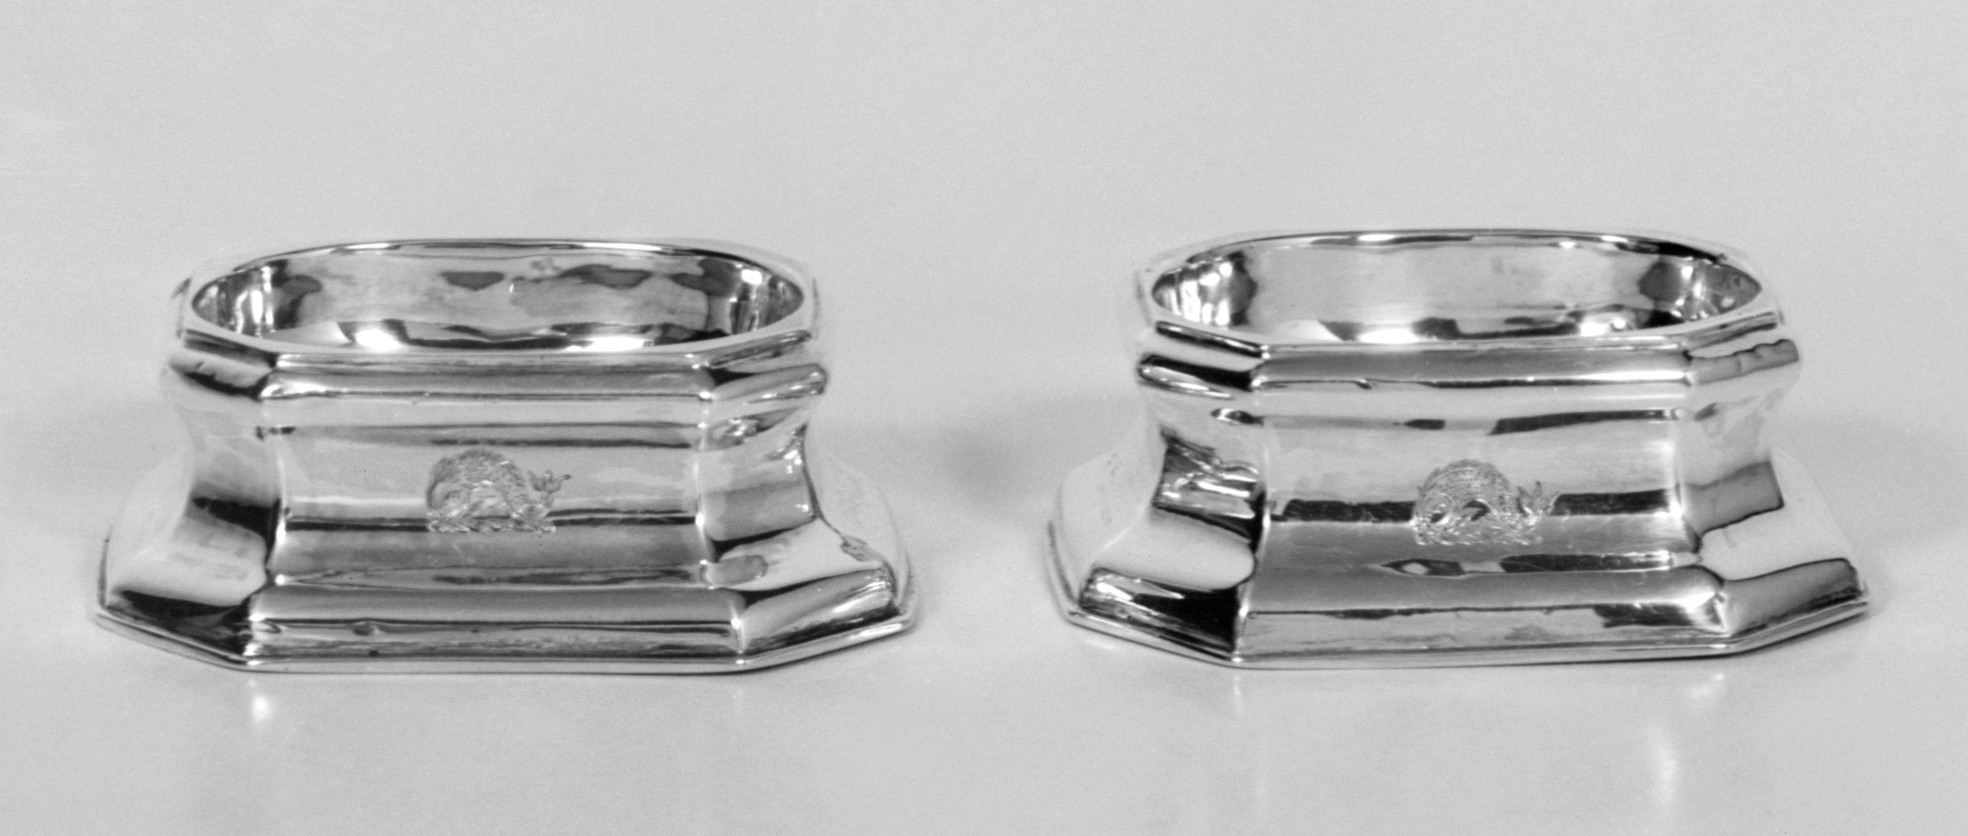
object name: saltcellar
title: Pair of saltcellars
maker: mary rood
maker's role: maker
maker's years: 1721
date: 1724-1725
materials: silver